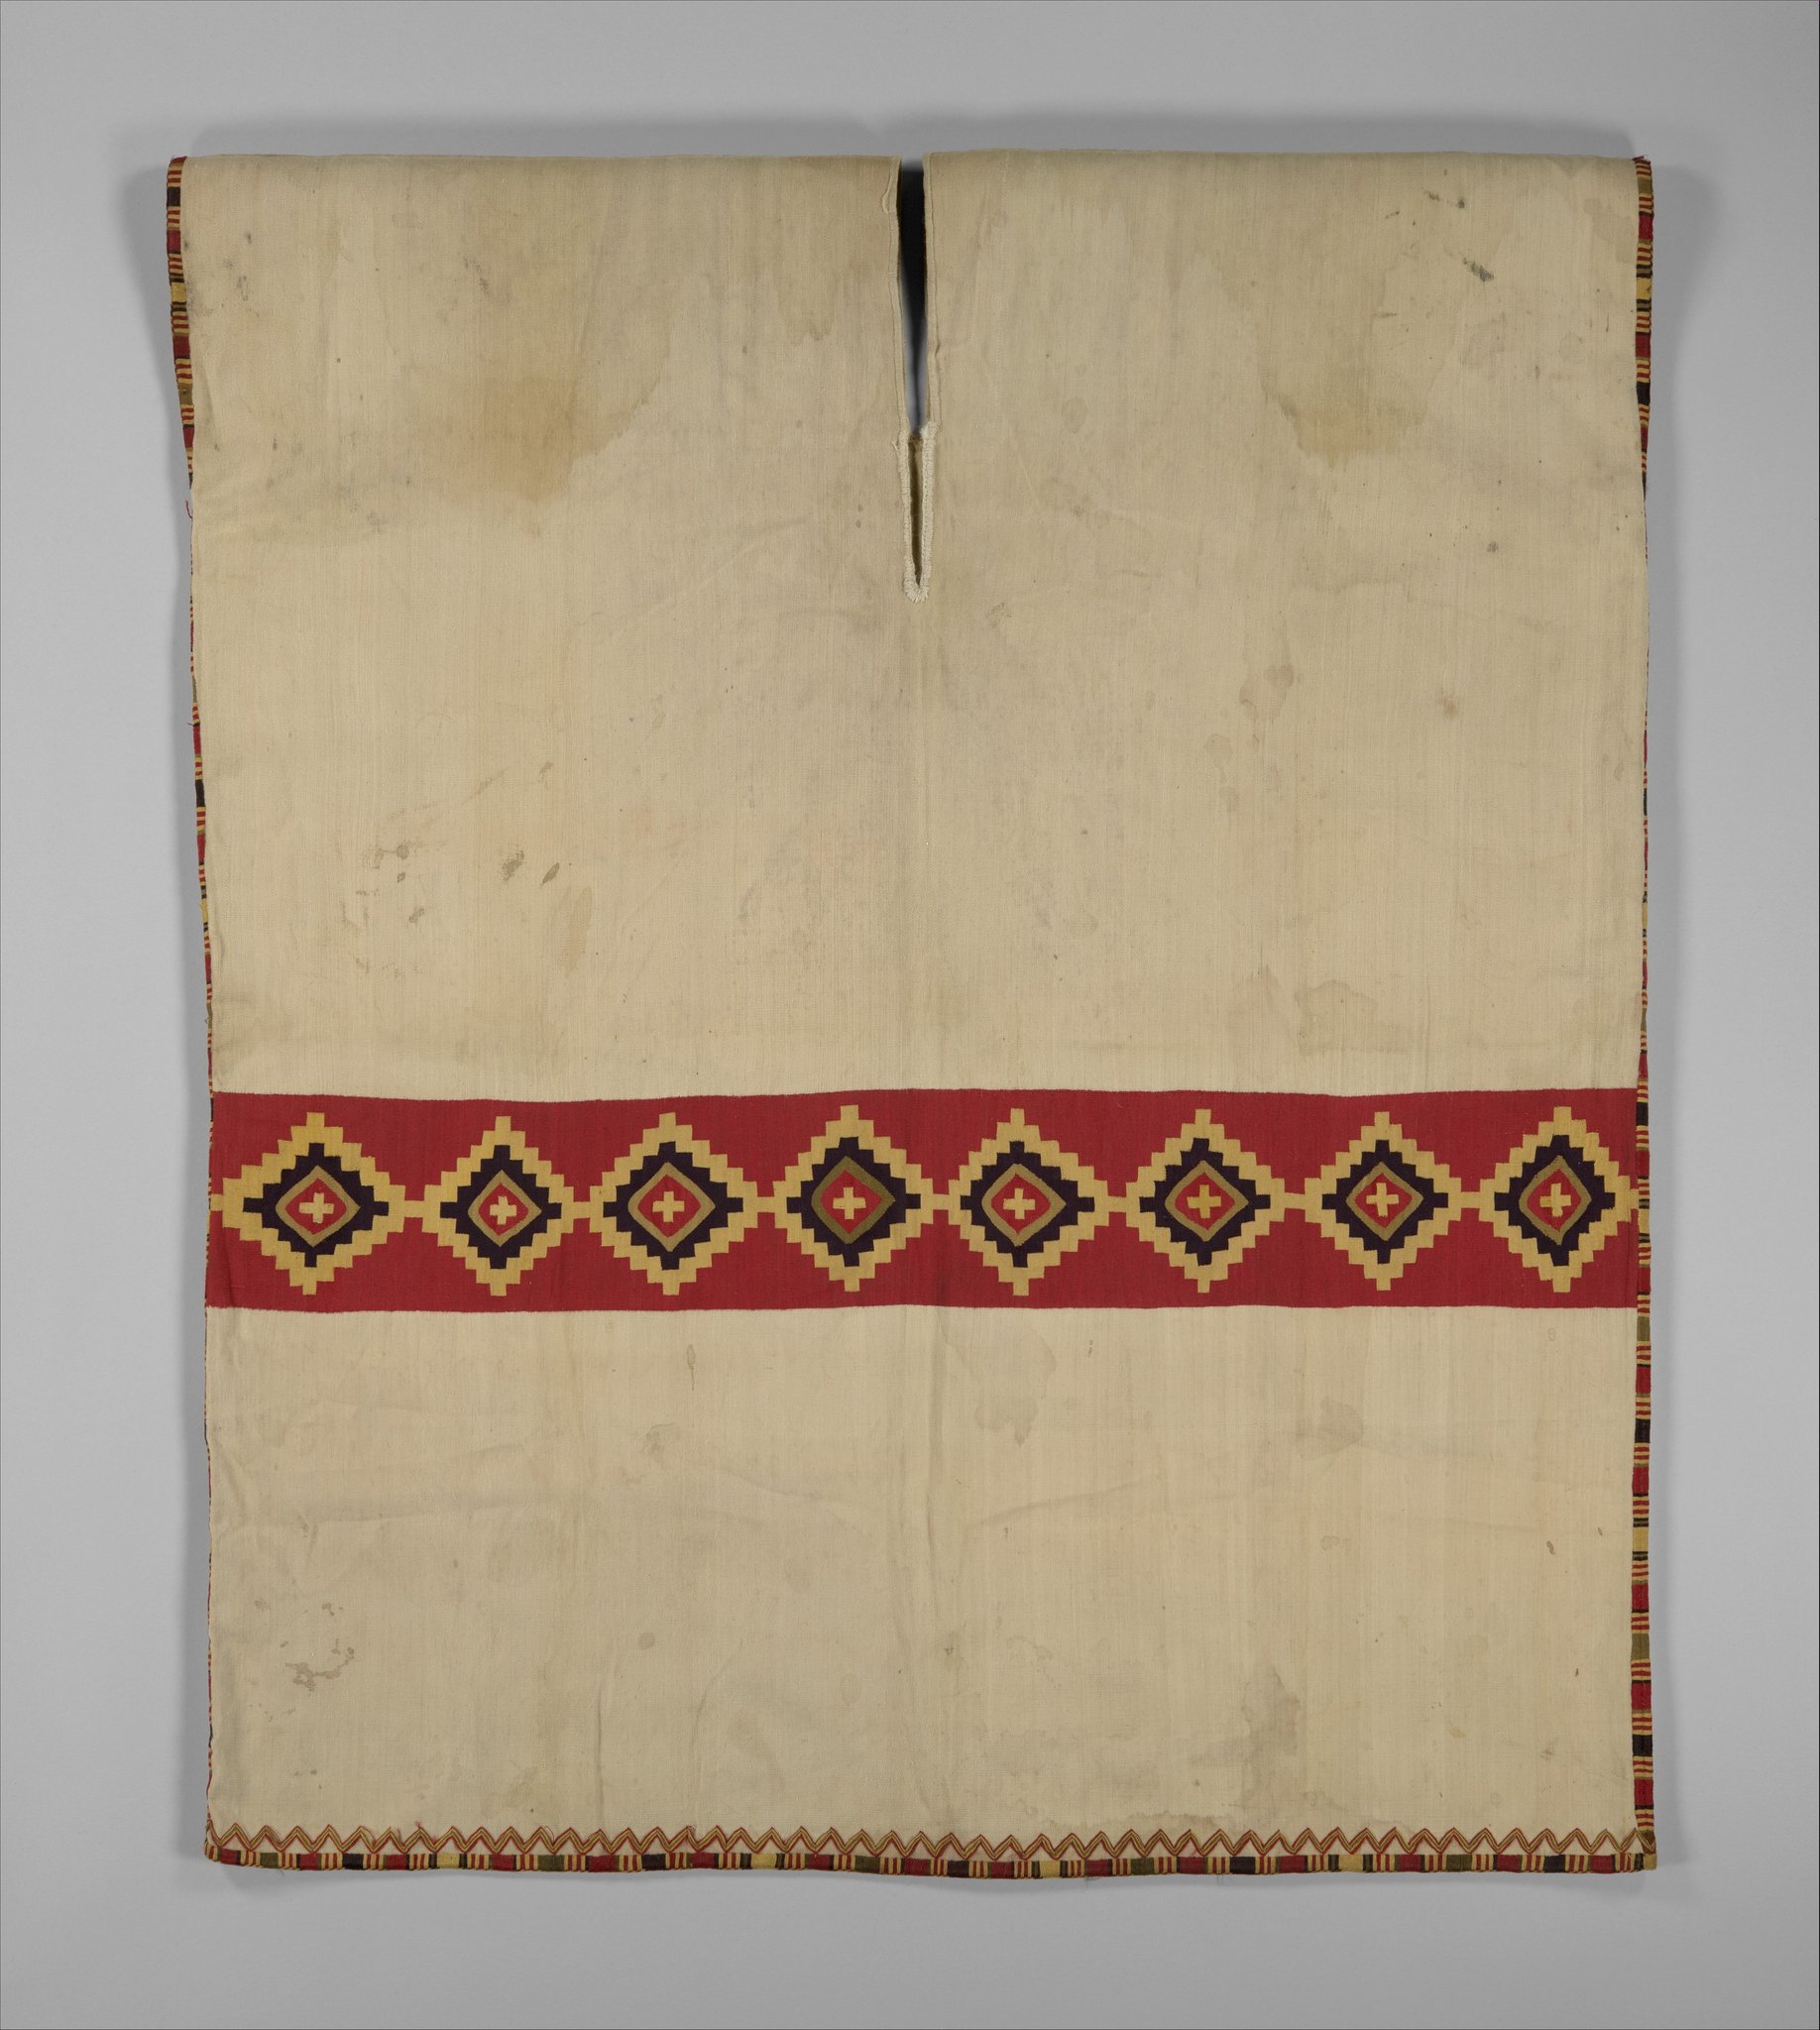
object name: tunic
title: Tunic with Diamond Band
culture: inca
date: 1460-1540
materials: animal fiber, cotton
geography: peru